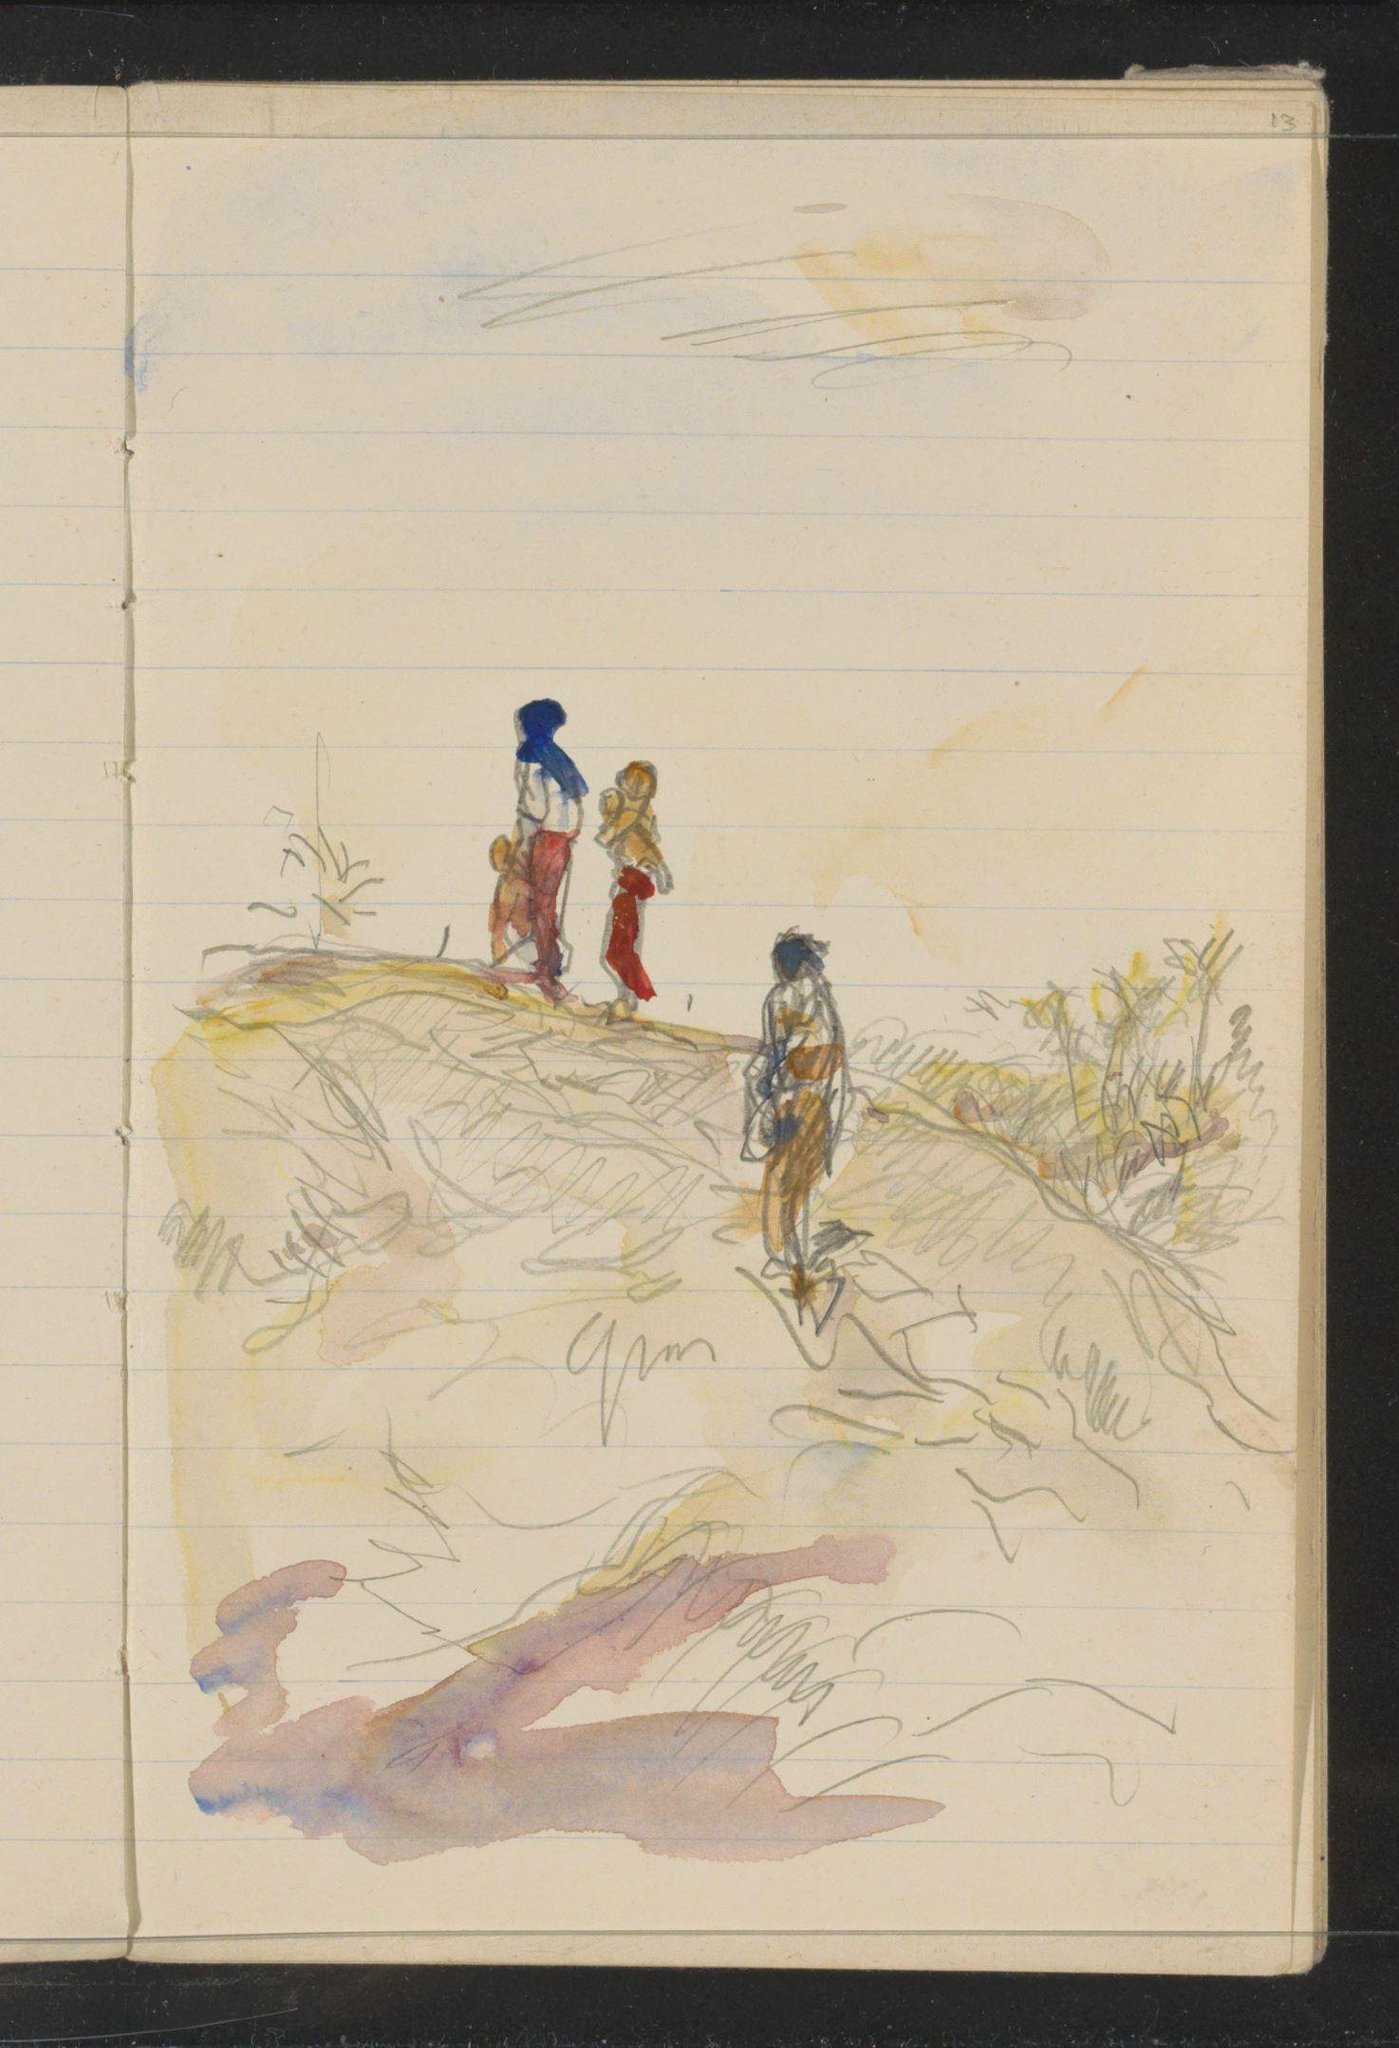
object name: sketchbook leaf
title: Figuren op een heuvel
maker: marius bauer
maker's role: draughtsman, print maker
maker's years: 1867-1932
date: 1931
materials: pencil, watercolor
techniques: brush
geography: java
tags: (high) hill, landscapes (+ landscape with figures, staffage)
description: Pagina 13 uit een schetsboek met 74 bladen.